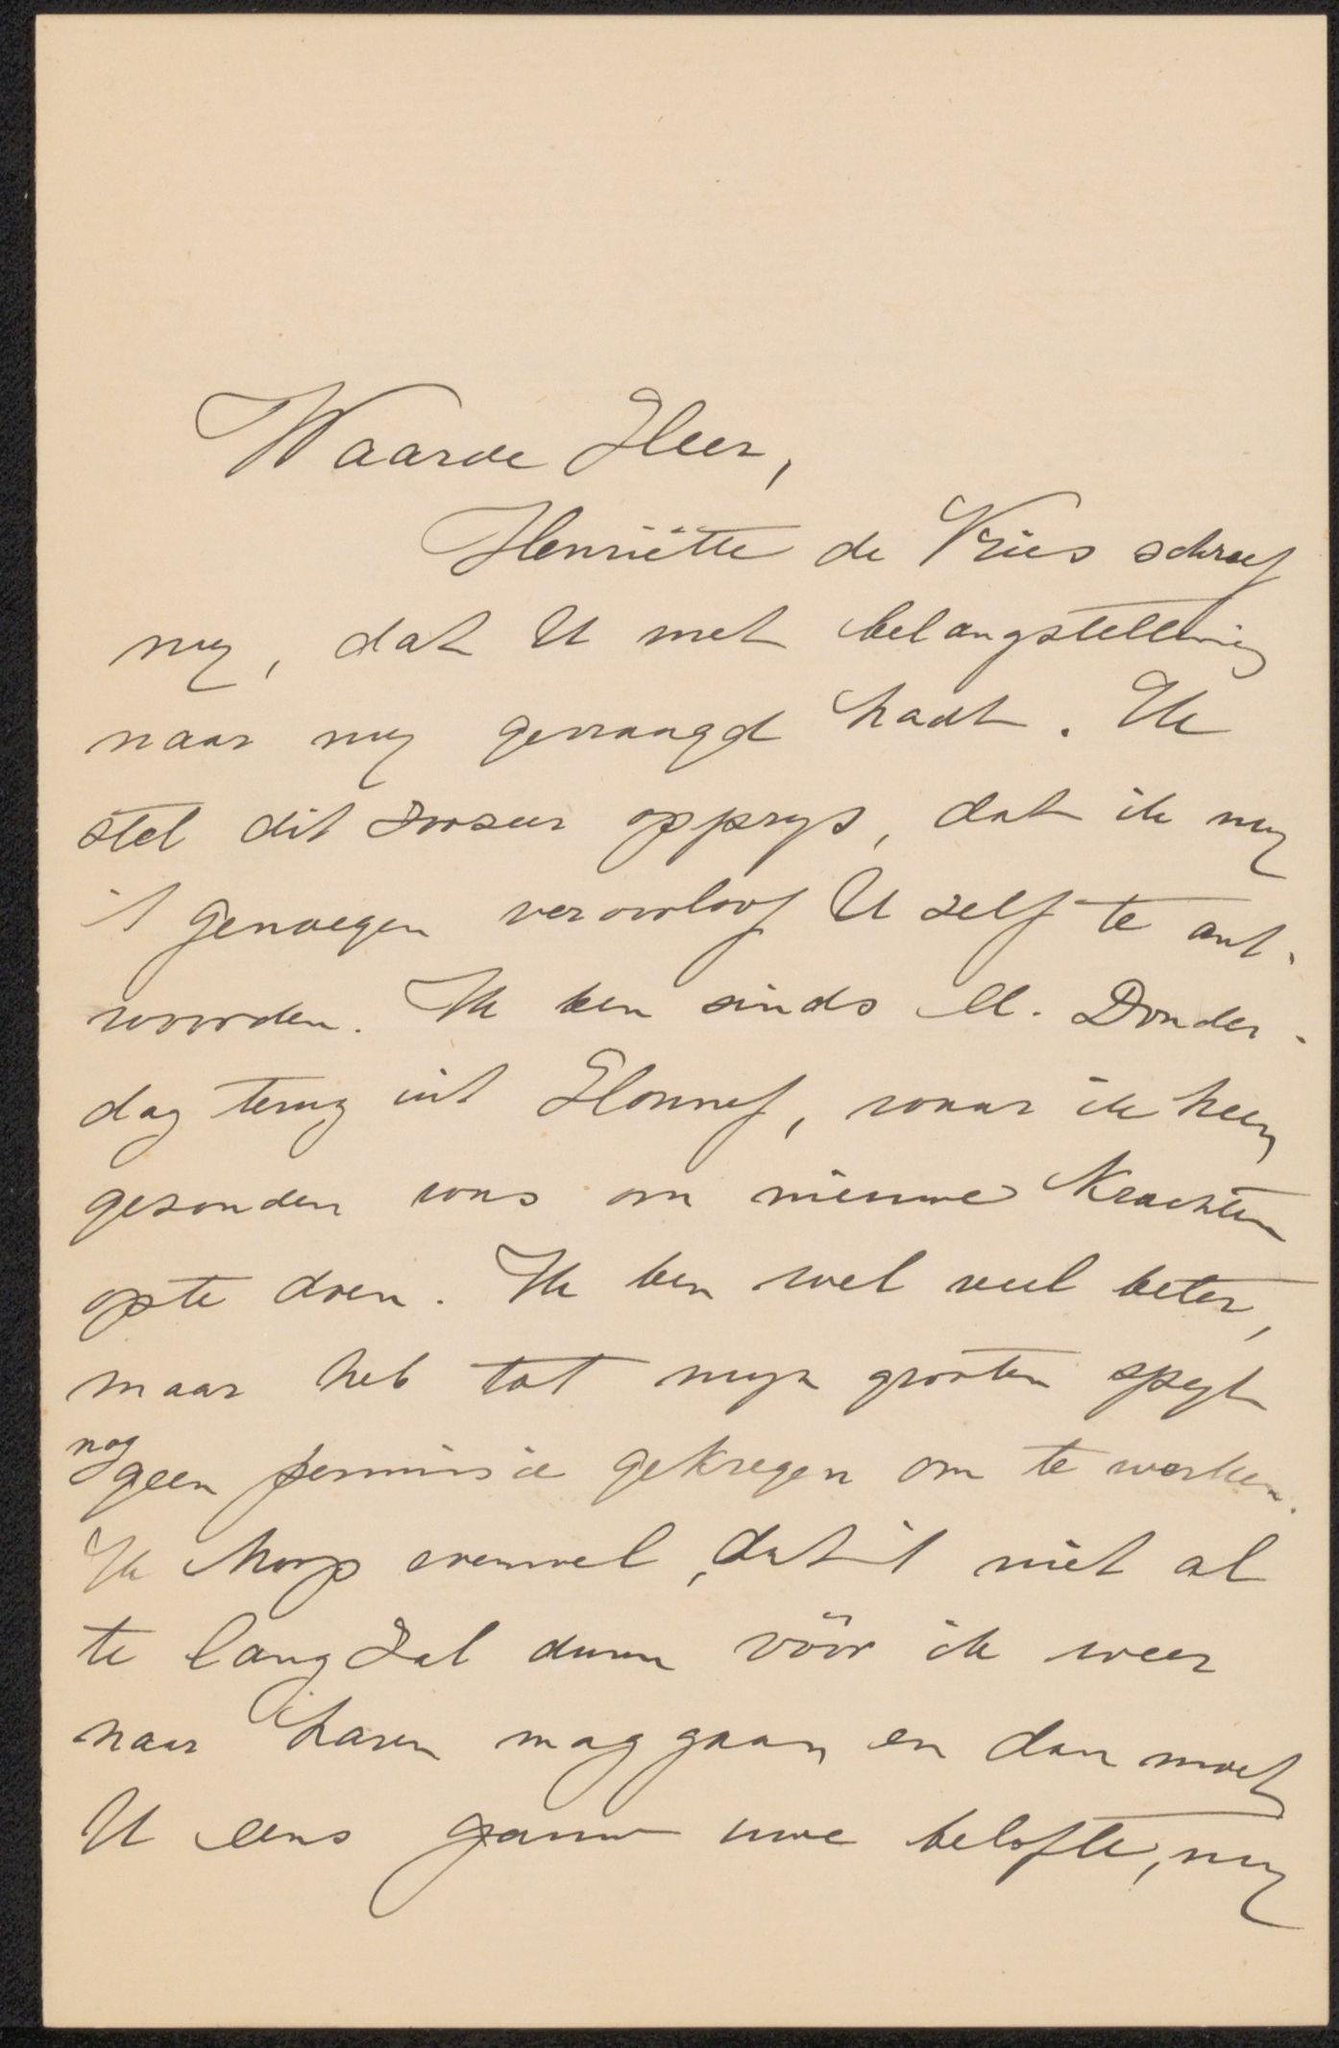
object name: letter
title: Brief aan August Allebé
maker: wally moes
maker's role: draughtsman, print maker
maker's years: 1856-1918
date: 1898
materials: ink, paper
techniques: pen, writing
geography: utrecht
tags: august allebé, amsterdam, draughtsman, henriëtte de vries, anonymous historical person portrayed, workshop, studio of the artist (in general), diseases